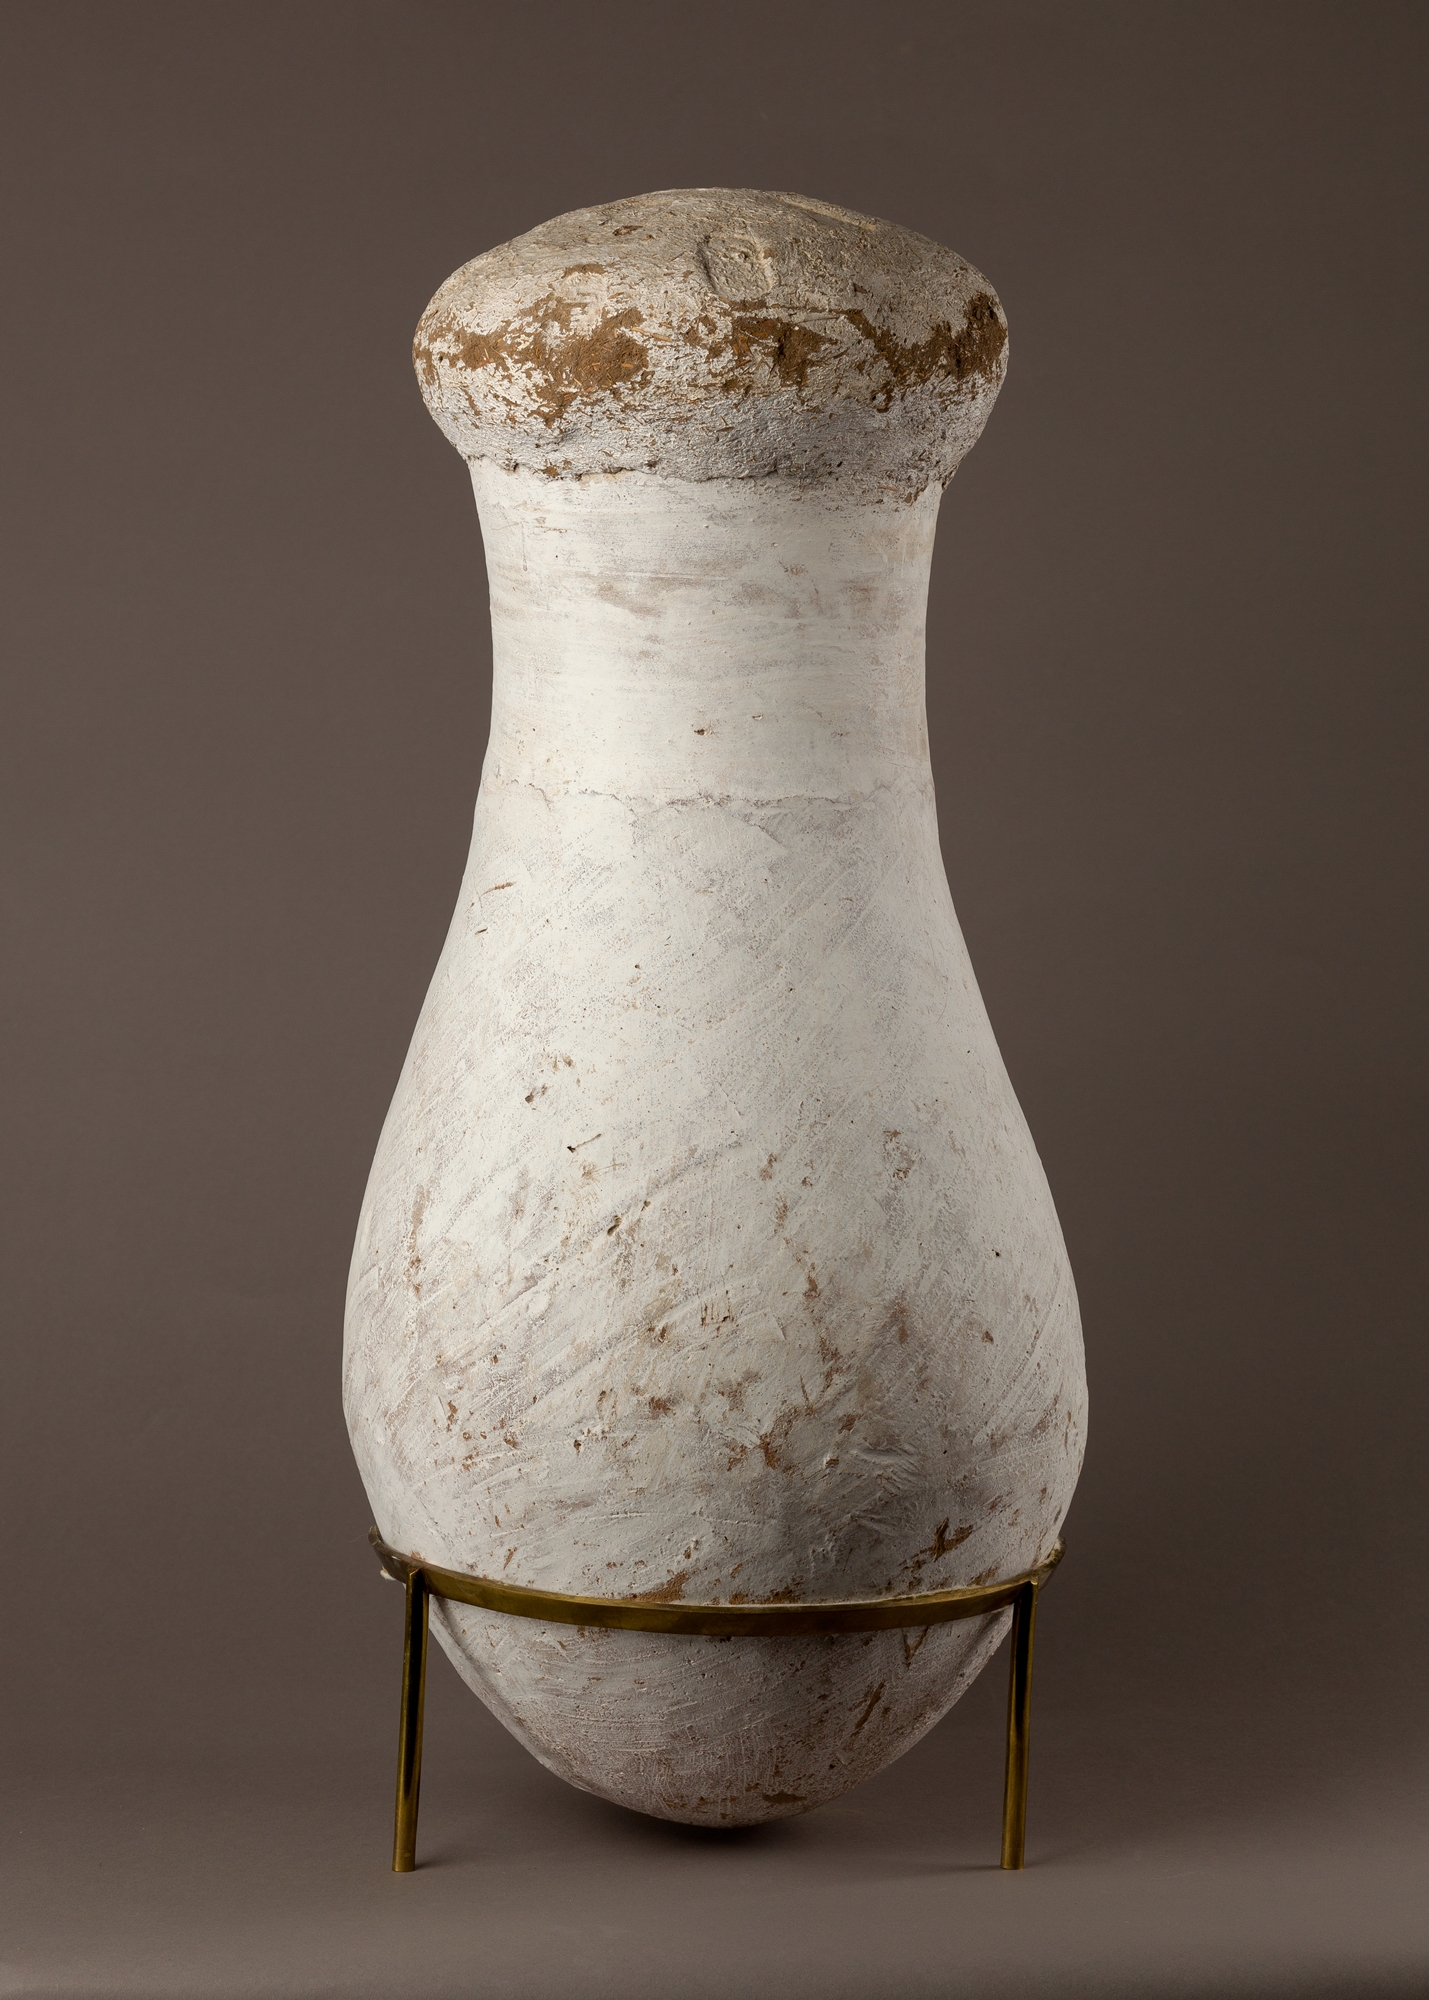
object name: jar, sealed, yuya and tjuyu kv 46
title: Sealed Jar from the Tomb of Yuya and Tjuyu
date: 1390-1352 BCE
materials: mud, pottery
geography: egypt